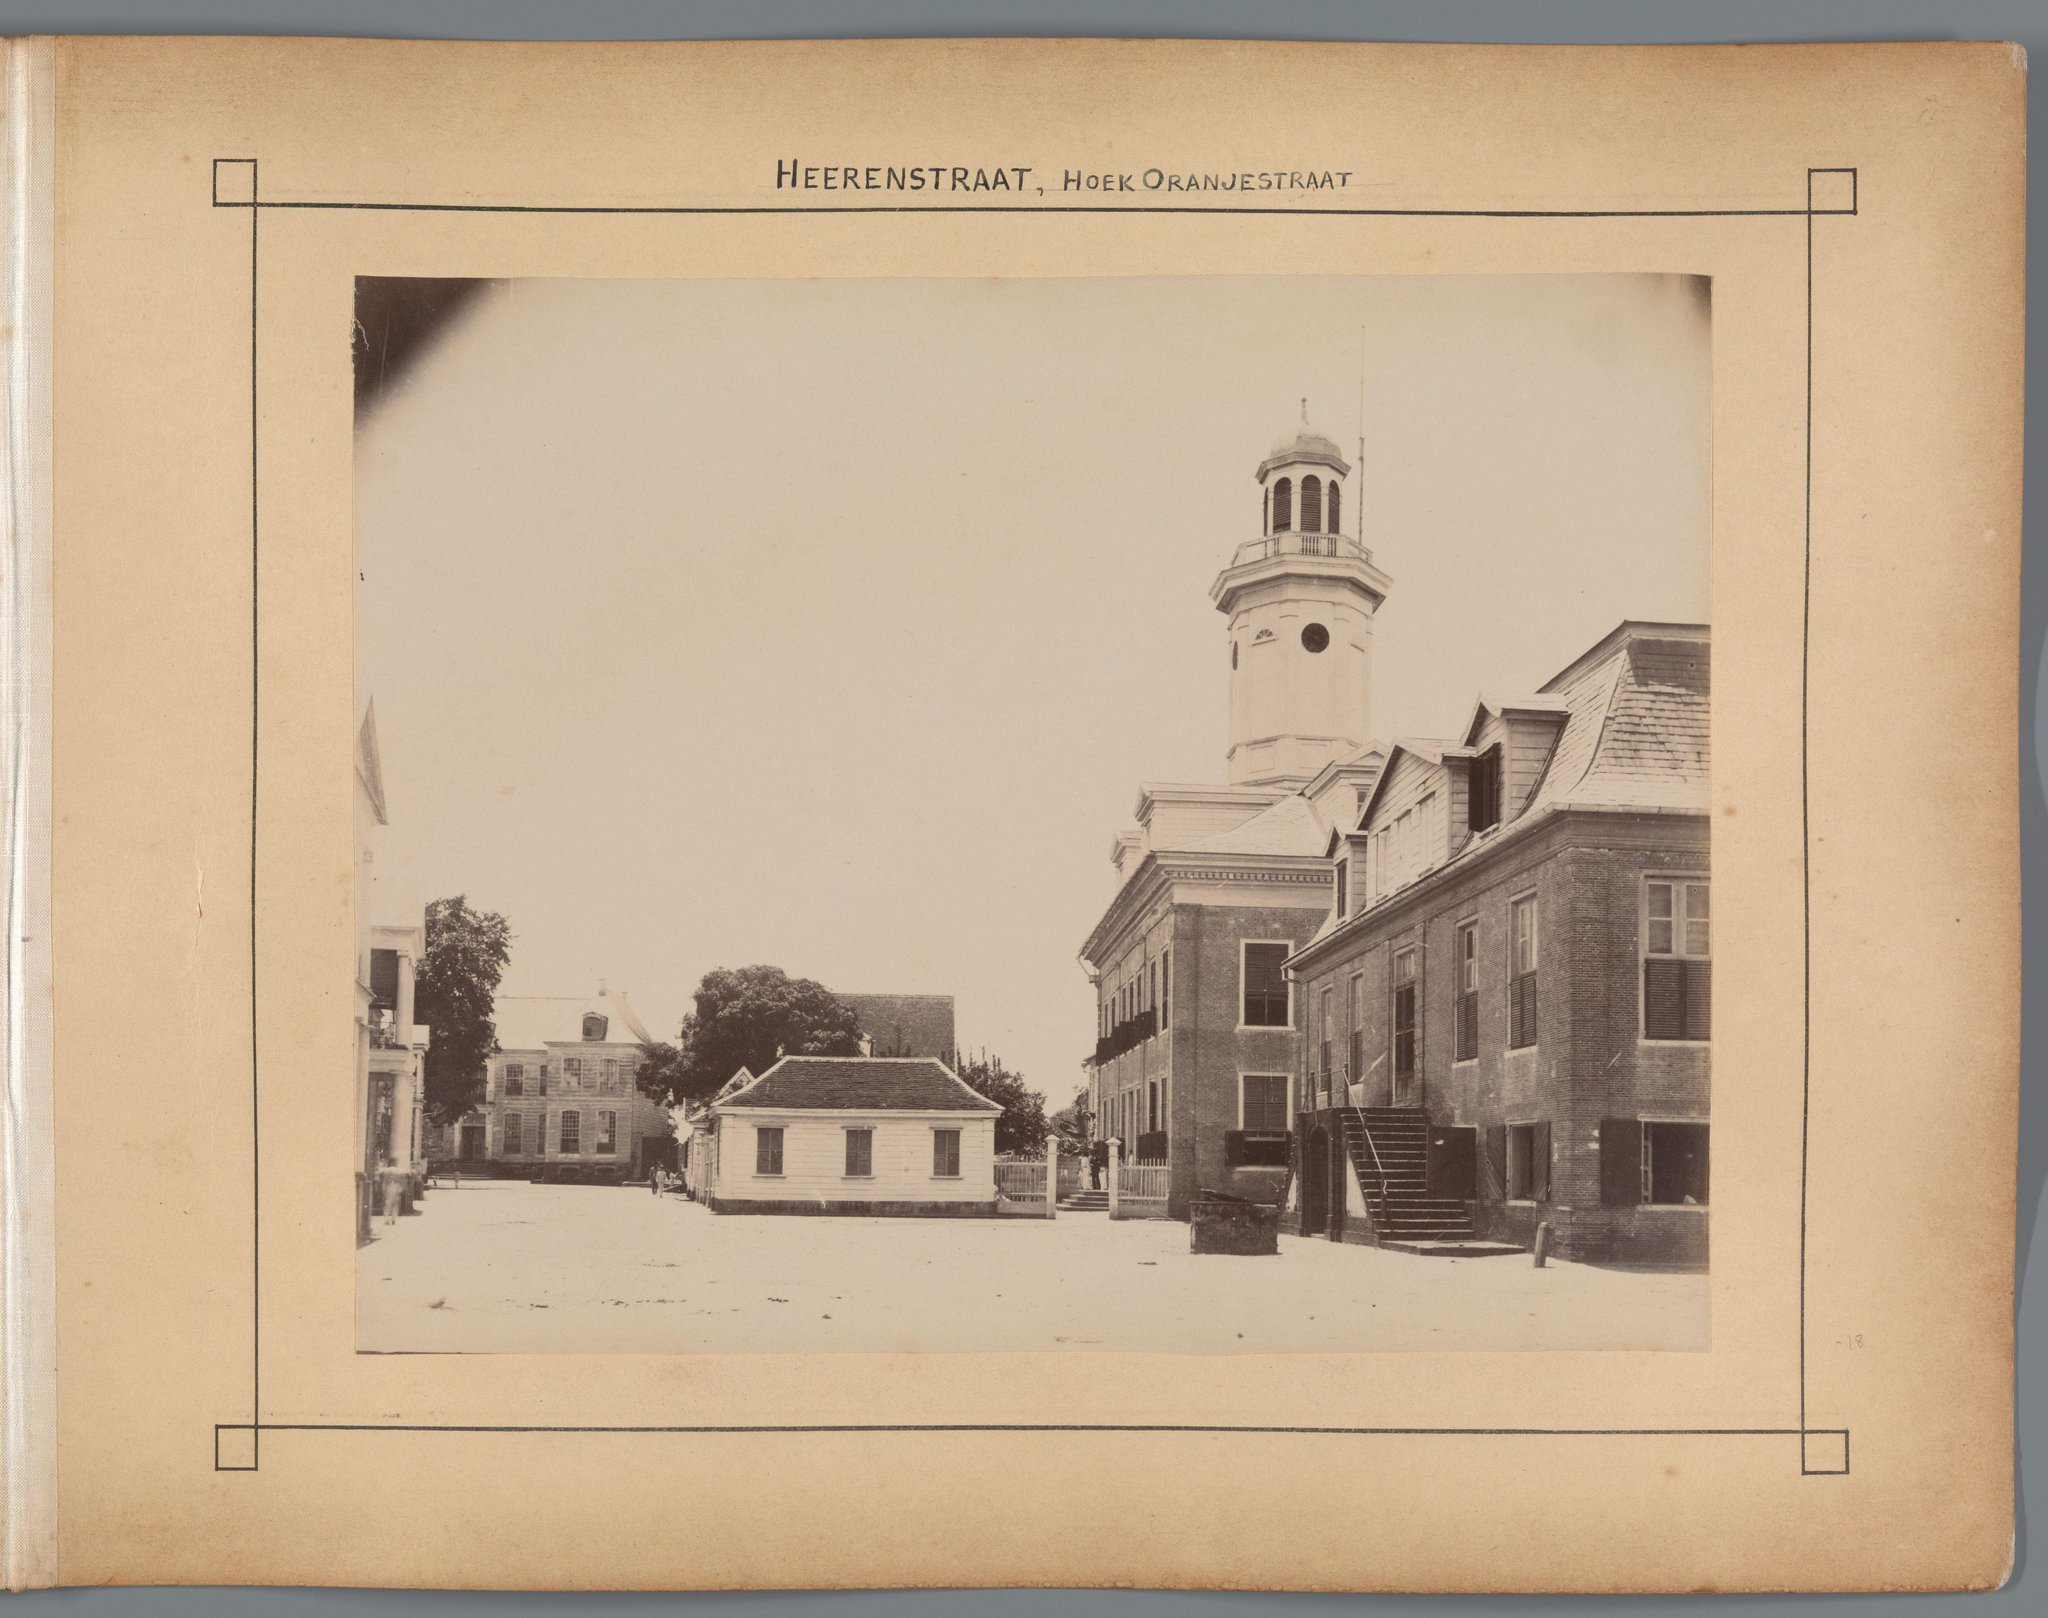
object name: photograph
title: Heerenstraat, hoek Oranjestraat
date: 1898-1902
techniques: albumen print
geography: suriname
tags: suriname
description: Heerenstraat, hoek Oranjestraat met het gebouw van het Ministerie van Financiën, Paramaribo.